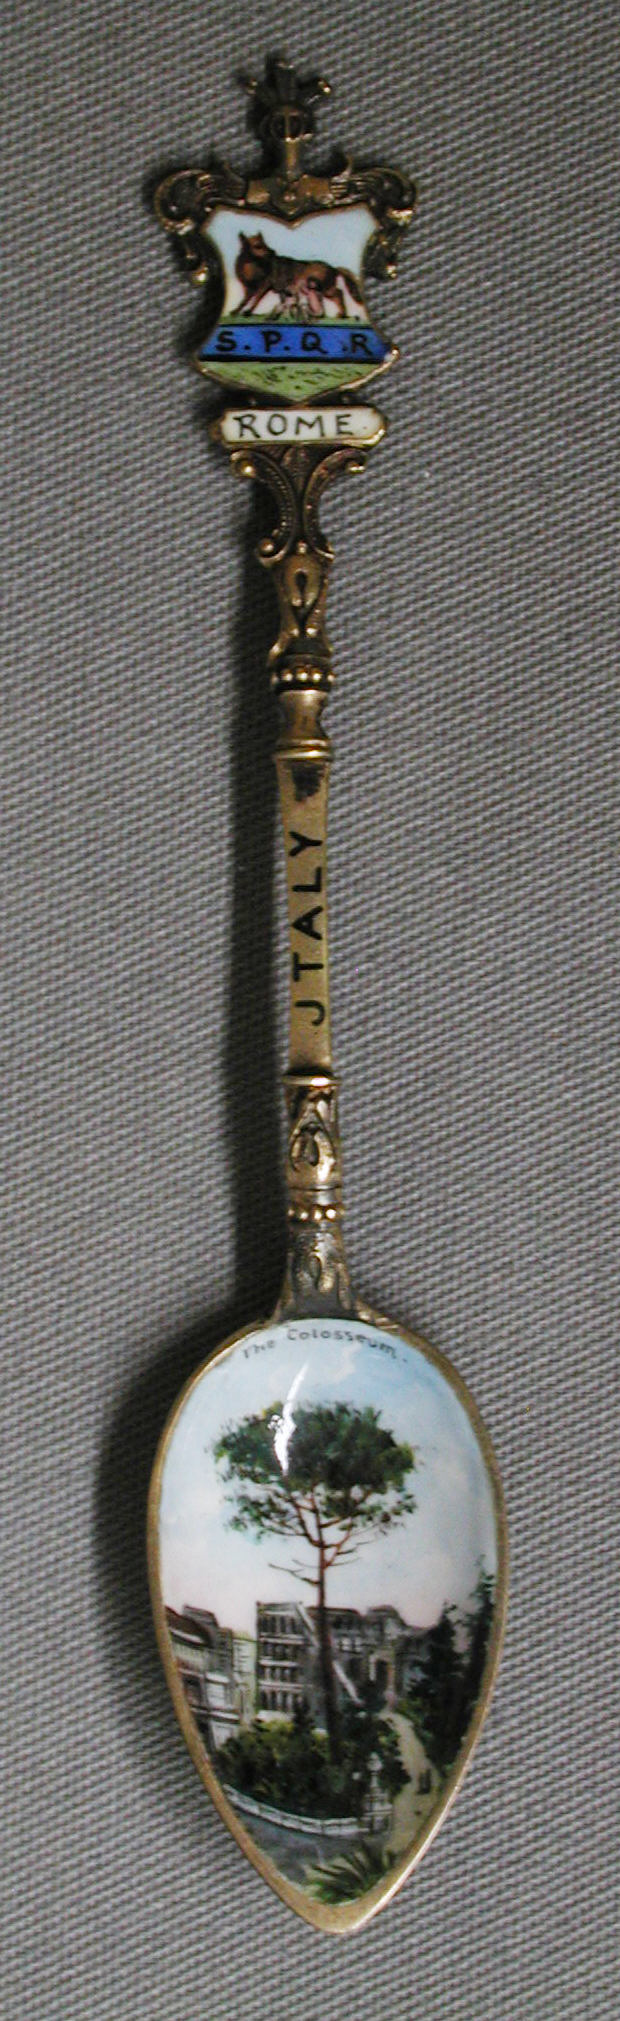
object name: souvenir spoon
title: Souvenir spoon with view of the Roman Colosseum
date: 1867-1900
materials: enamel, silver gilt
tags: buildings,trees,coat of arms